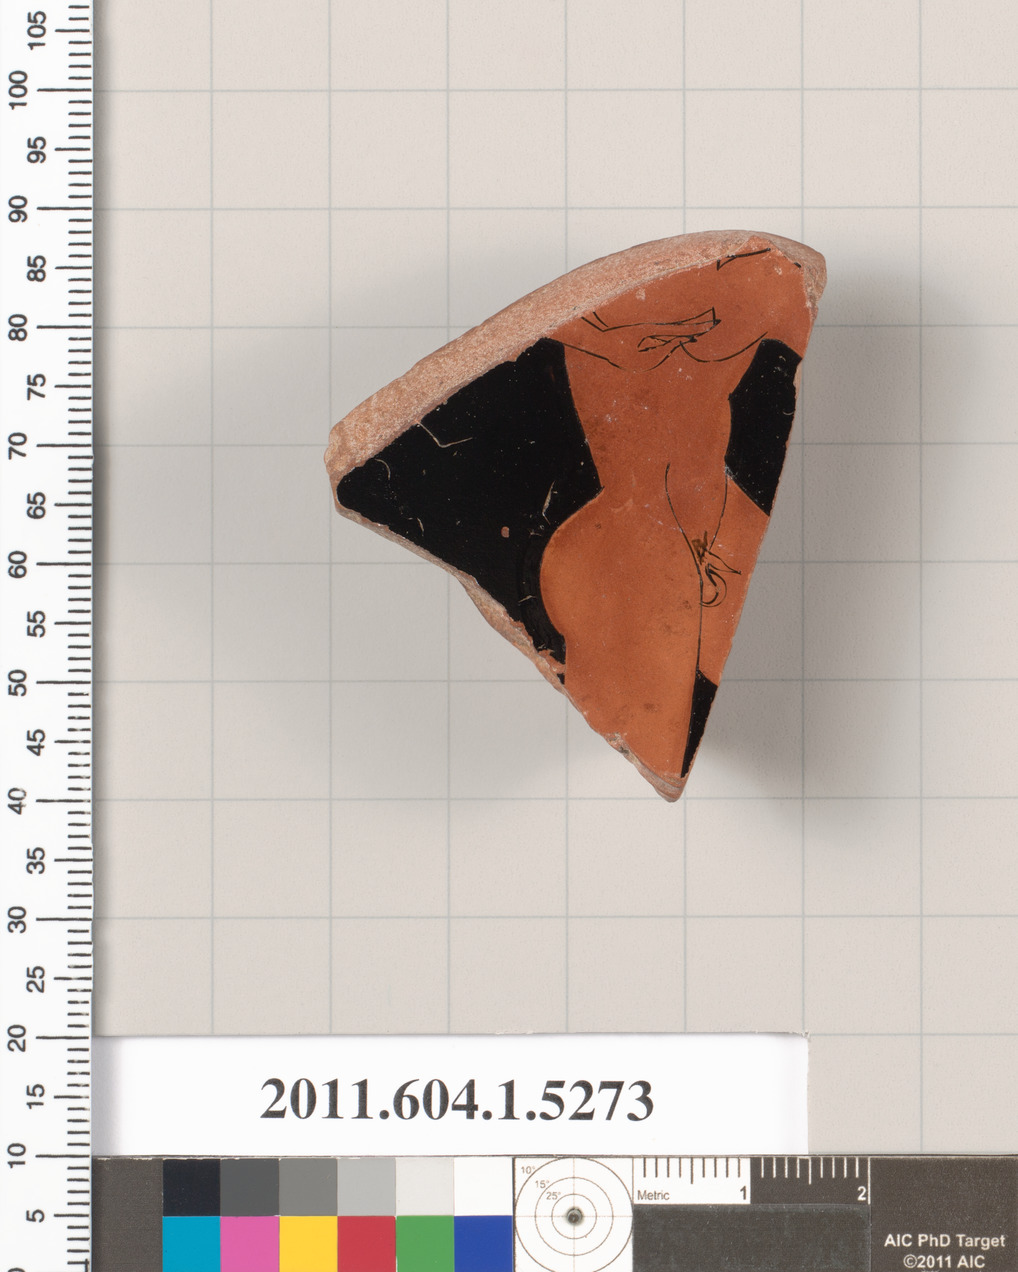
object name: kylix fragment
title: Terracotta fragment of a kylix (drinking cup)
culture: greek, attic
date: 500-480 BCE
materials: terracotta